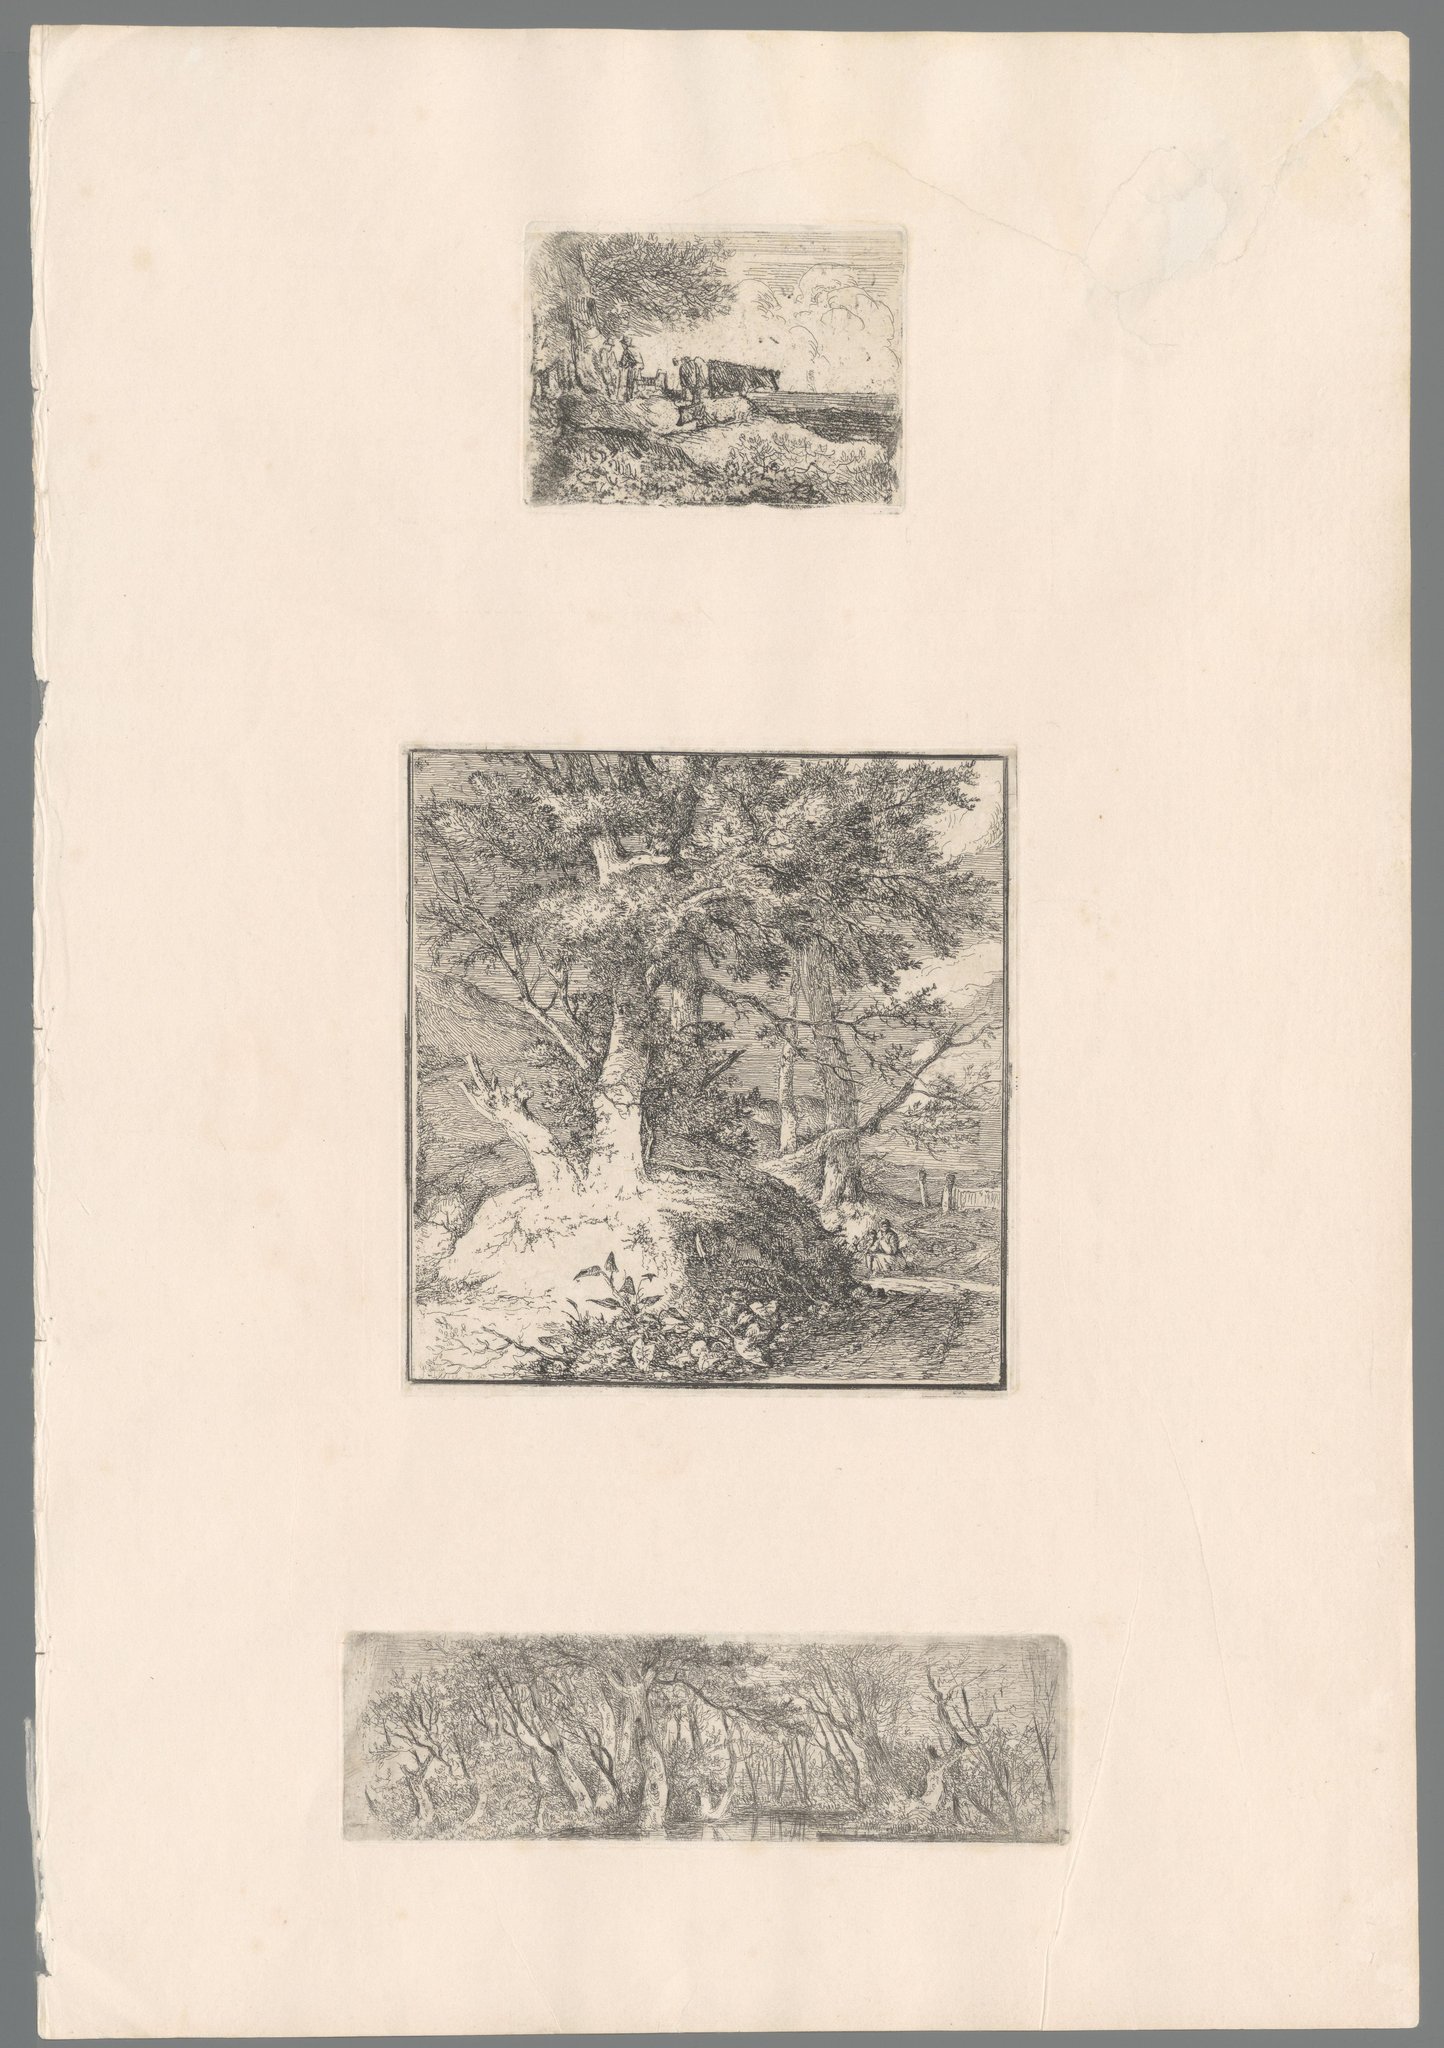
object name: print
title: A Composition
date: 1834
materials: paper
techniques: etching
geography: norwich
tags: low hill country, trees, road, path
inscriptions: collector's mark: Lugt 2228, collector's mark: Lugt 2760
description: Prent staat samen met RP-P-1973-182 en RP-P-1973-184 op een onversneden blad.